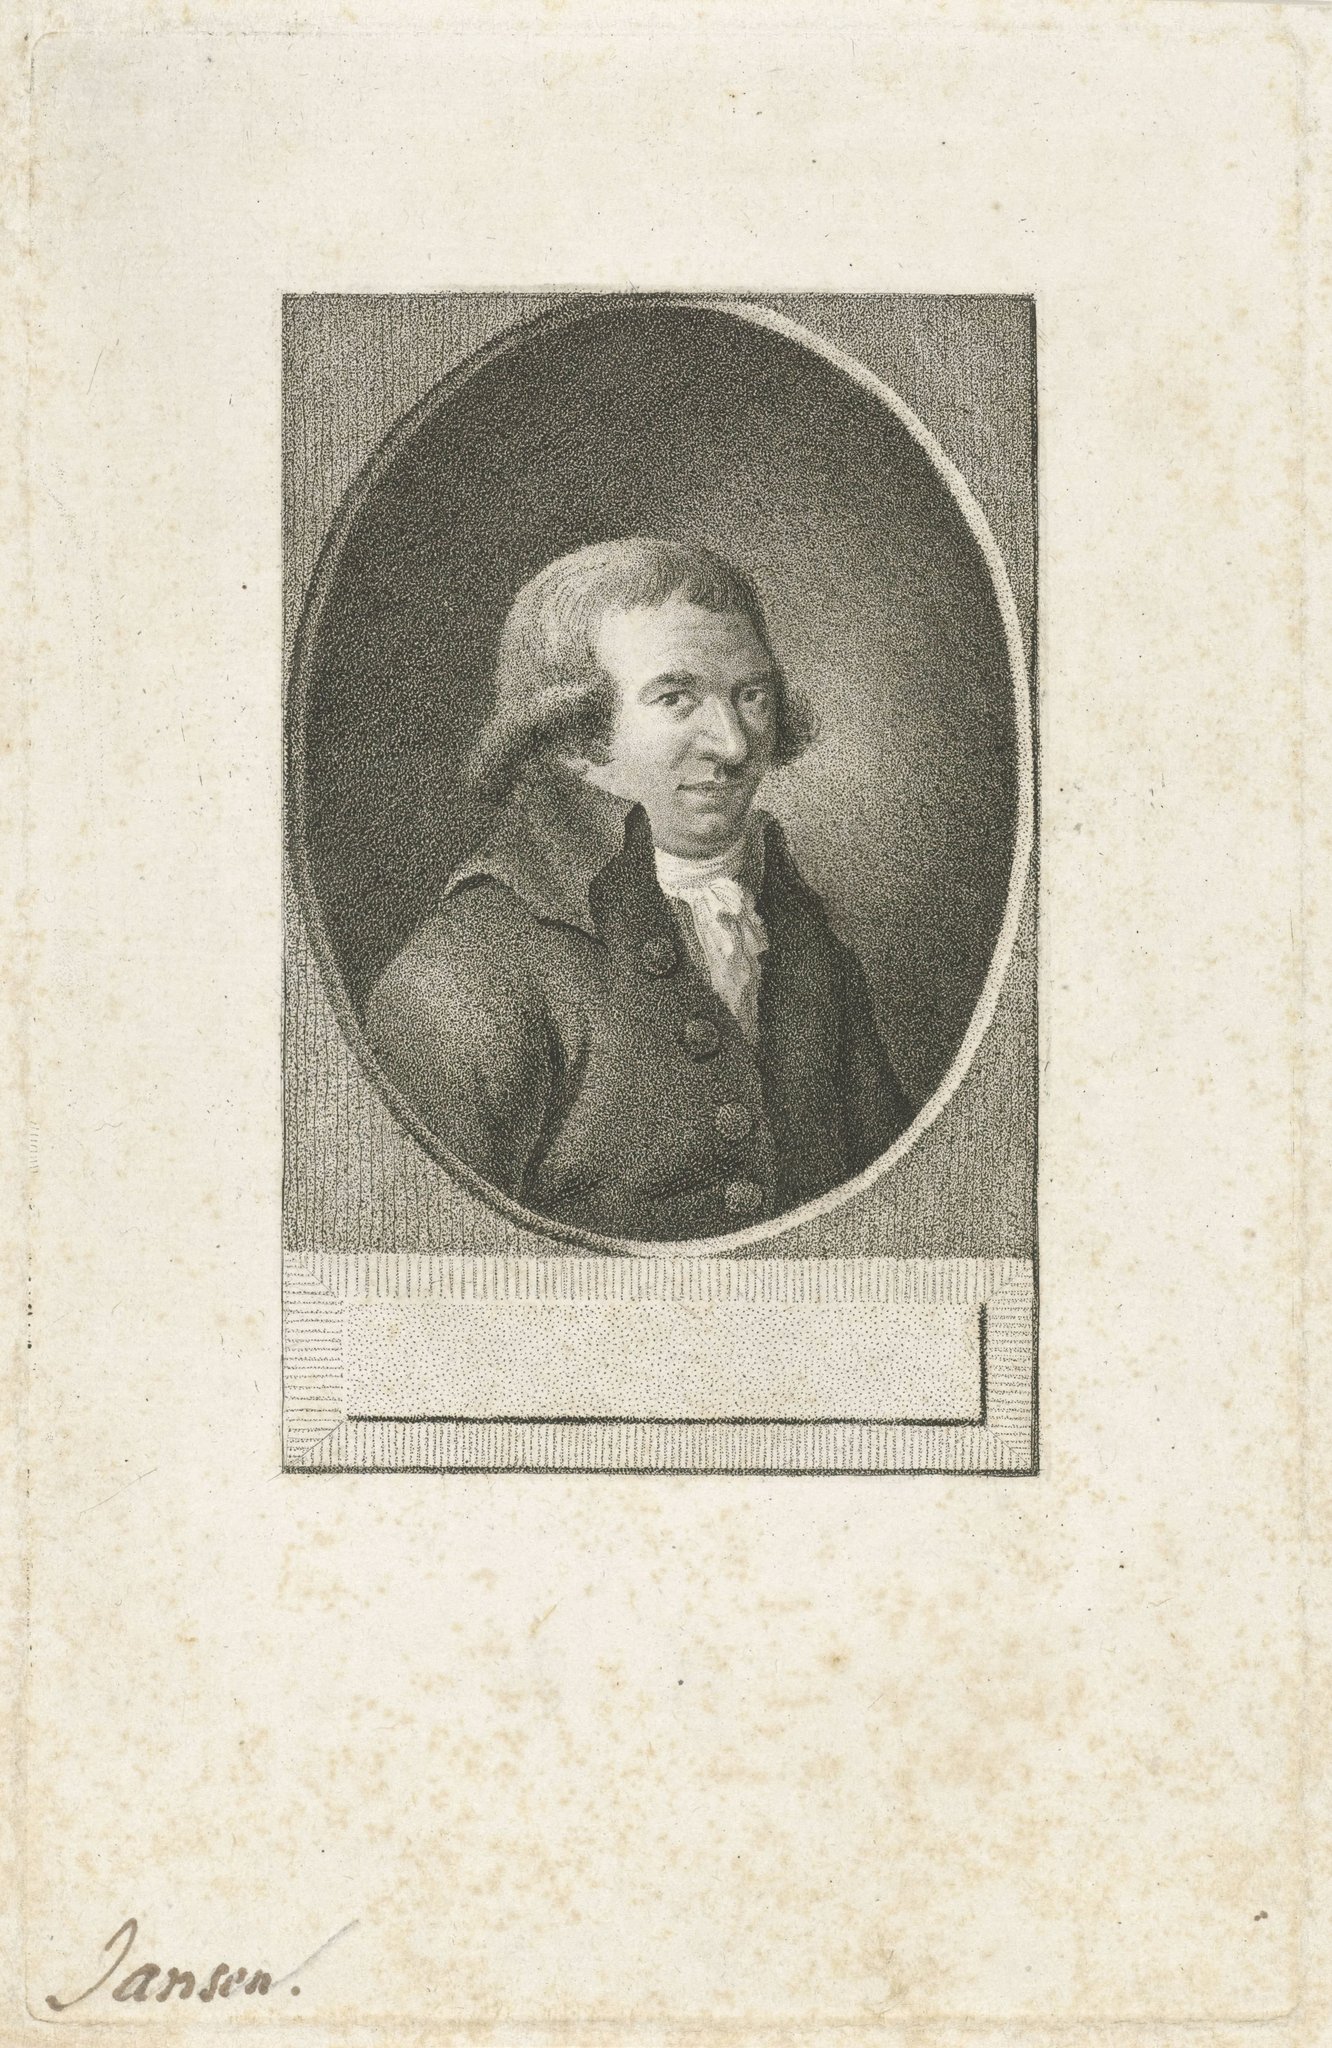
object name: print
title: Portret van een onbekende man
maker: françois joseph pfeiffer (i)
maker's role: print maker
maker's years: 1741-1807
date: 1756-1807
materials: paper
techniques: aquatint, etching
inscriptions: collector's mark: Lugt 2228, inscription: ‘Jansen.’